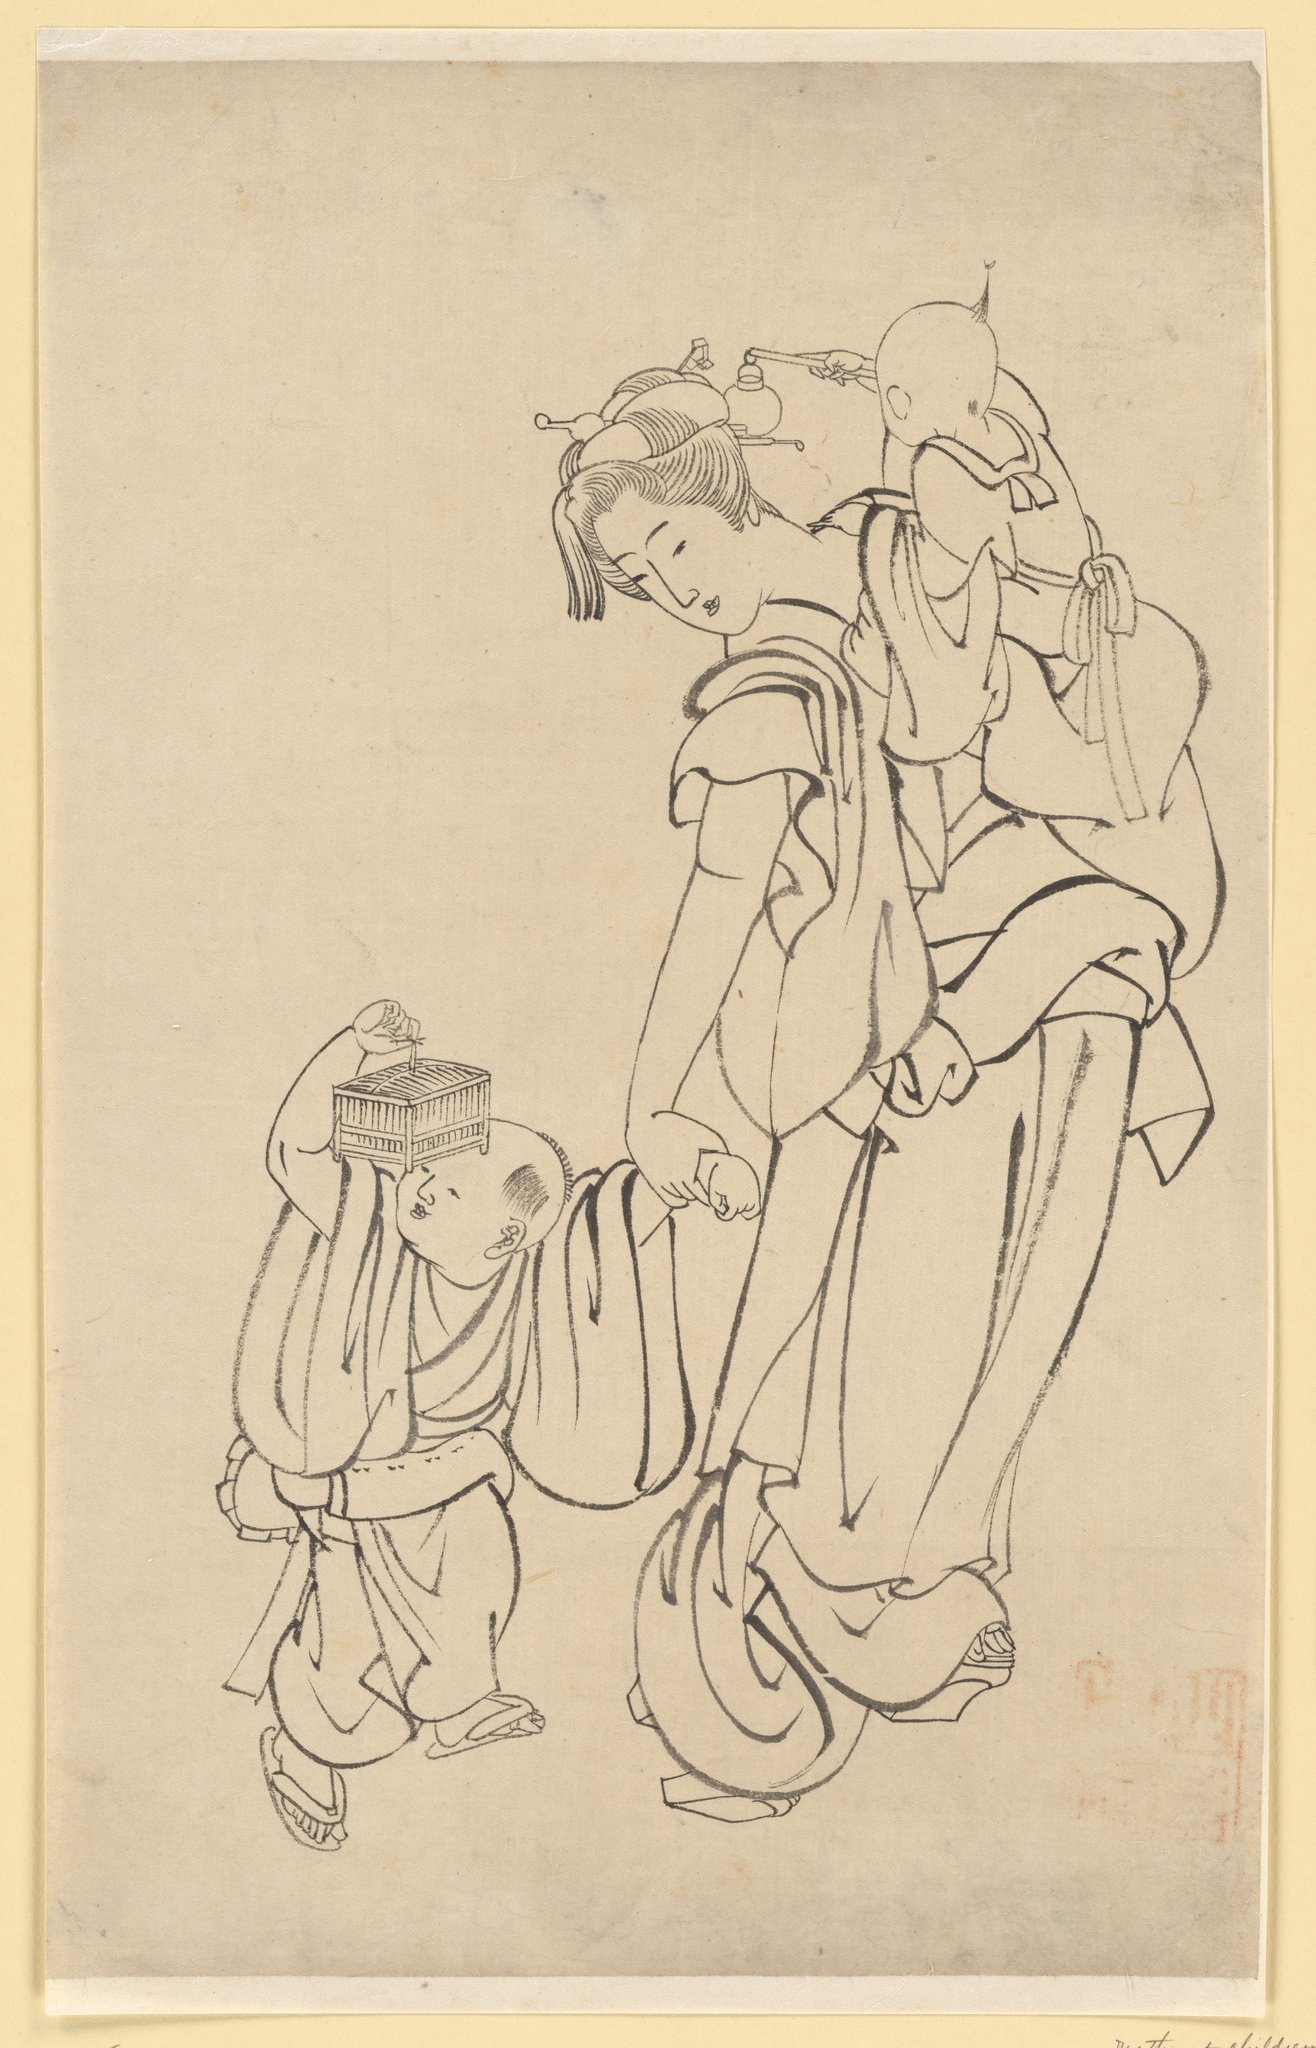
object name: drawing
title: Mother and Children in Summer Night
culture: japanese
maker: katsushika hokusai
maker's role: artist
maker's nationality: japanese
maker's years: 1760-1849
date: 1701-1900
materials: ink, paper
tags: children,infants,mothers